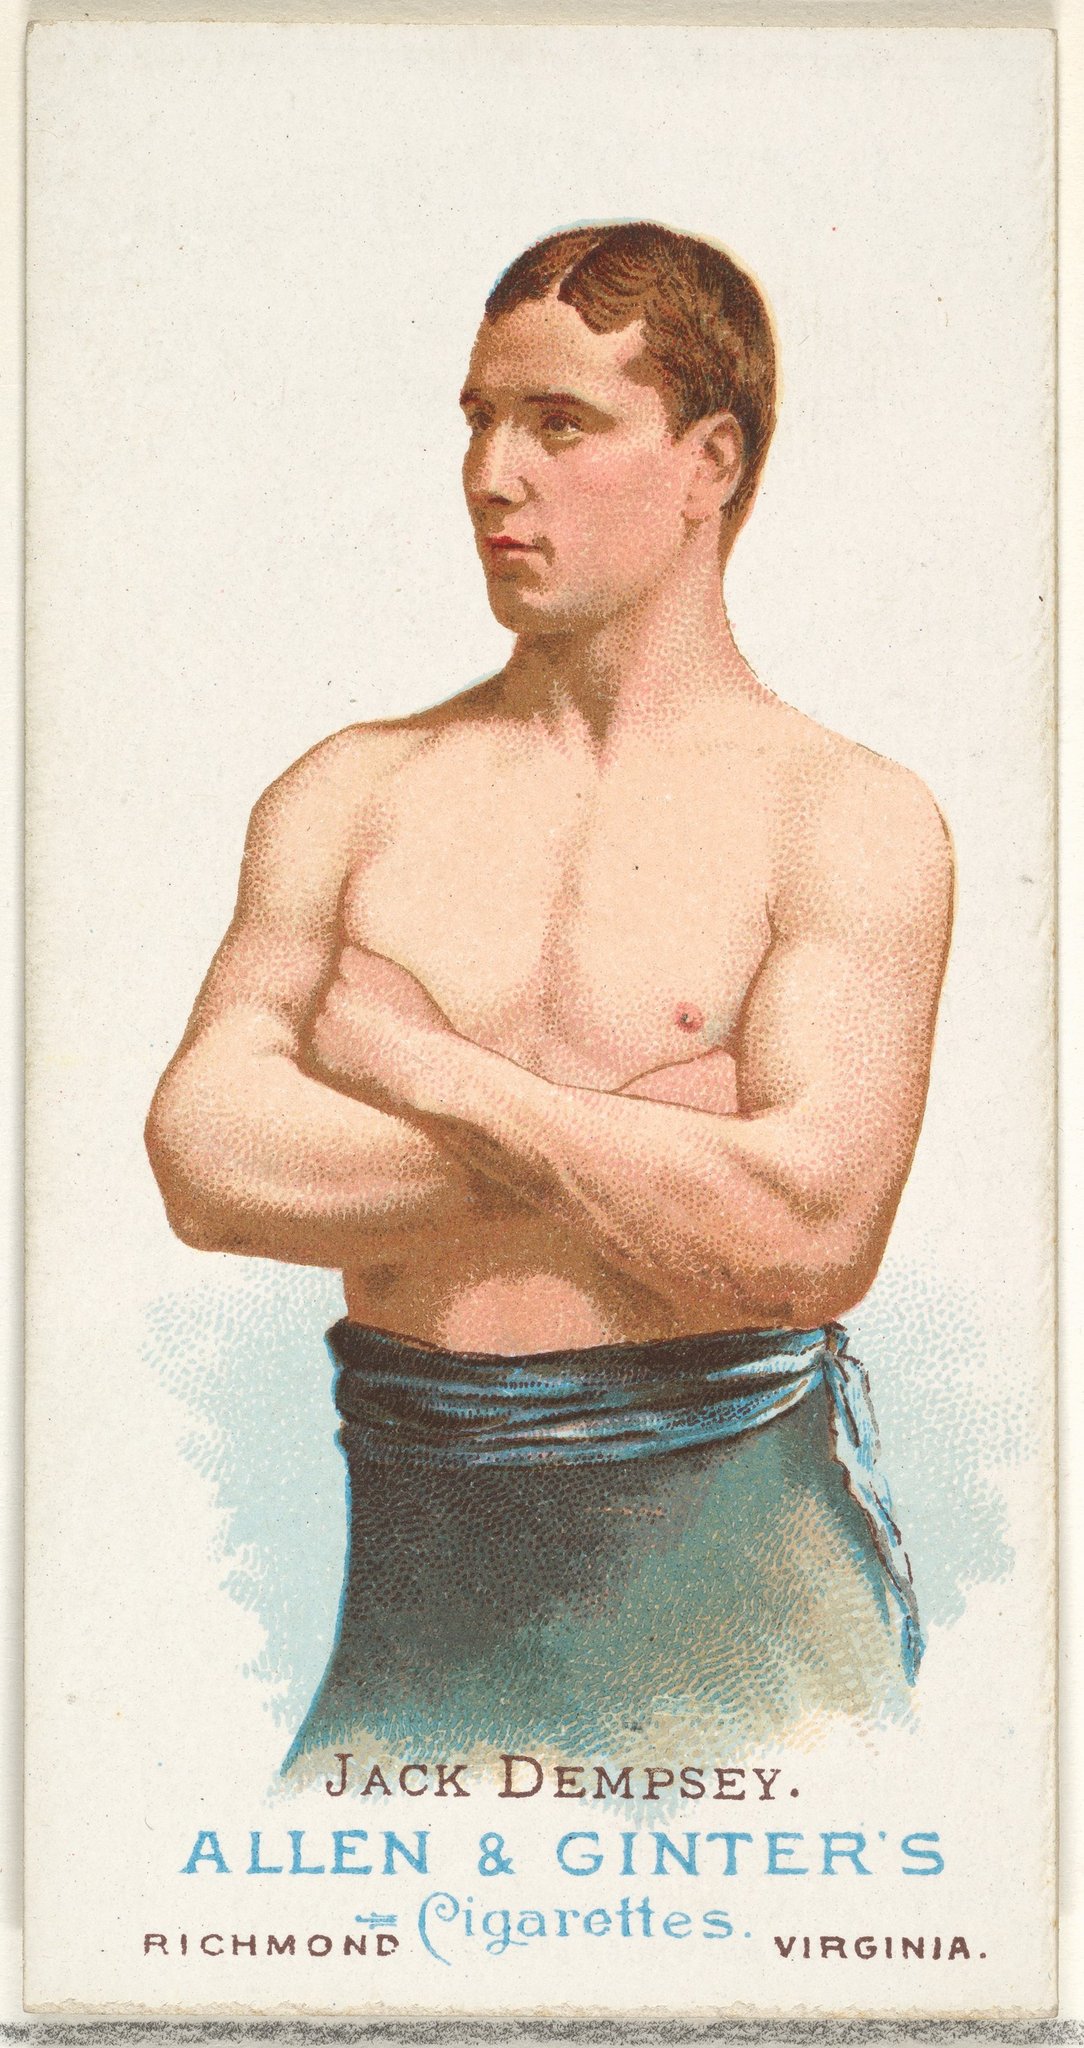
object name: print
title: Jack Dempsey, Pugilist, from World's Champions, Series 1 (N28) for Allen & Ginter Cigarettes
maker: allen & ginter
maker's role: publisher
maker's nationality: american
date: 1887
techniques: color lithograph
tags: men,portraits,boxing